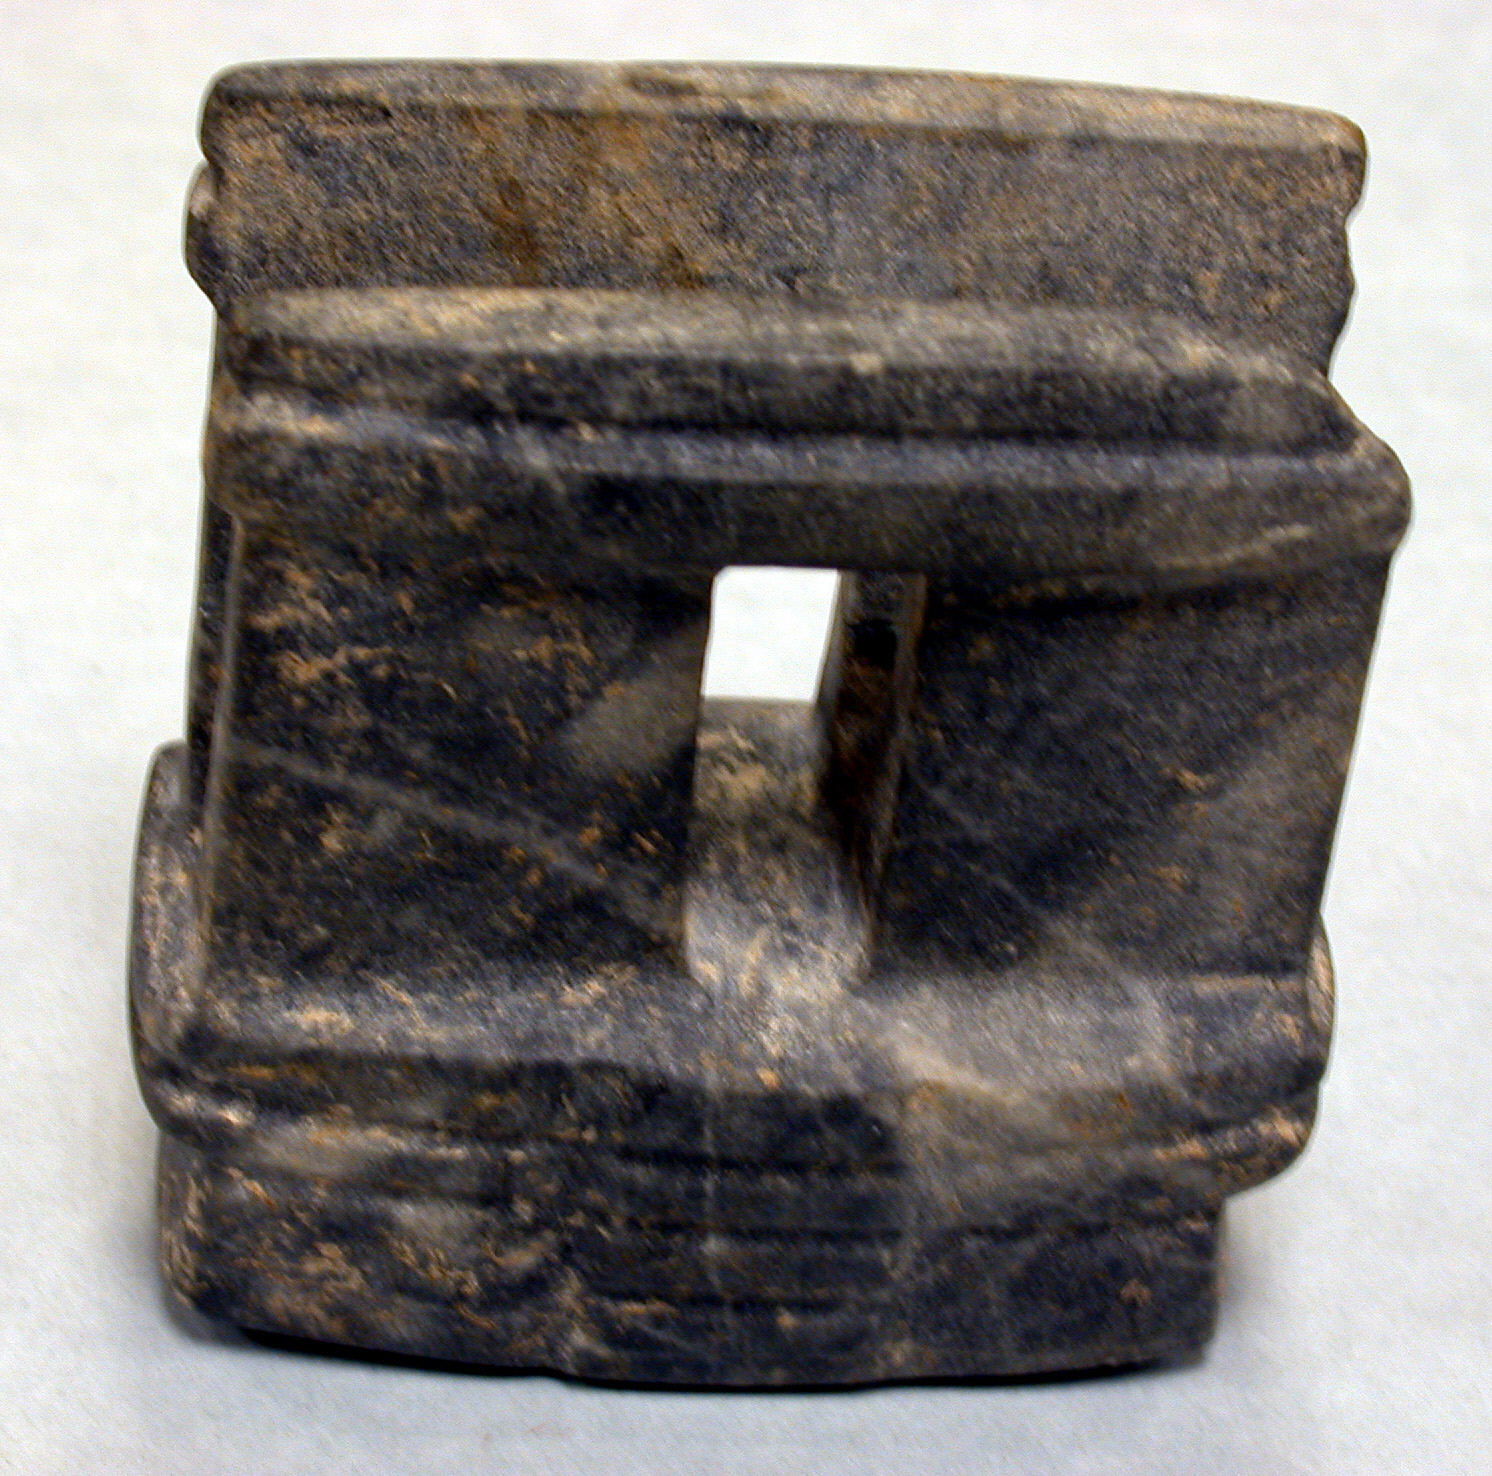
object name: architectural model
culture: mezcala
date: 1-800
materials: stone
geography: mexico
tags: temples